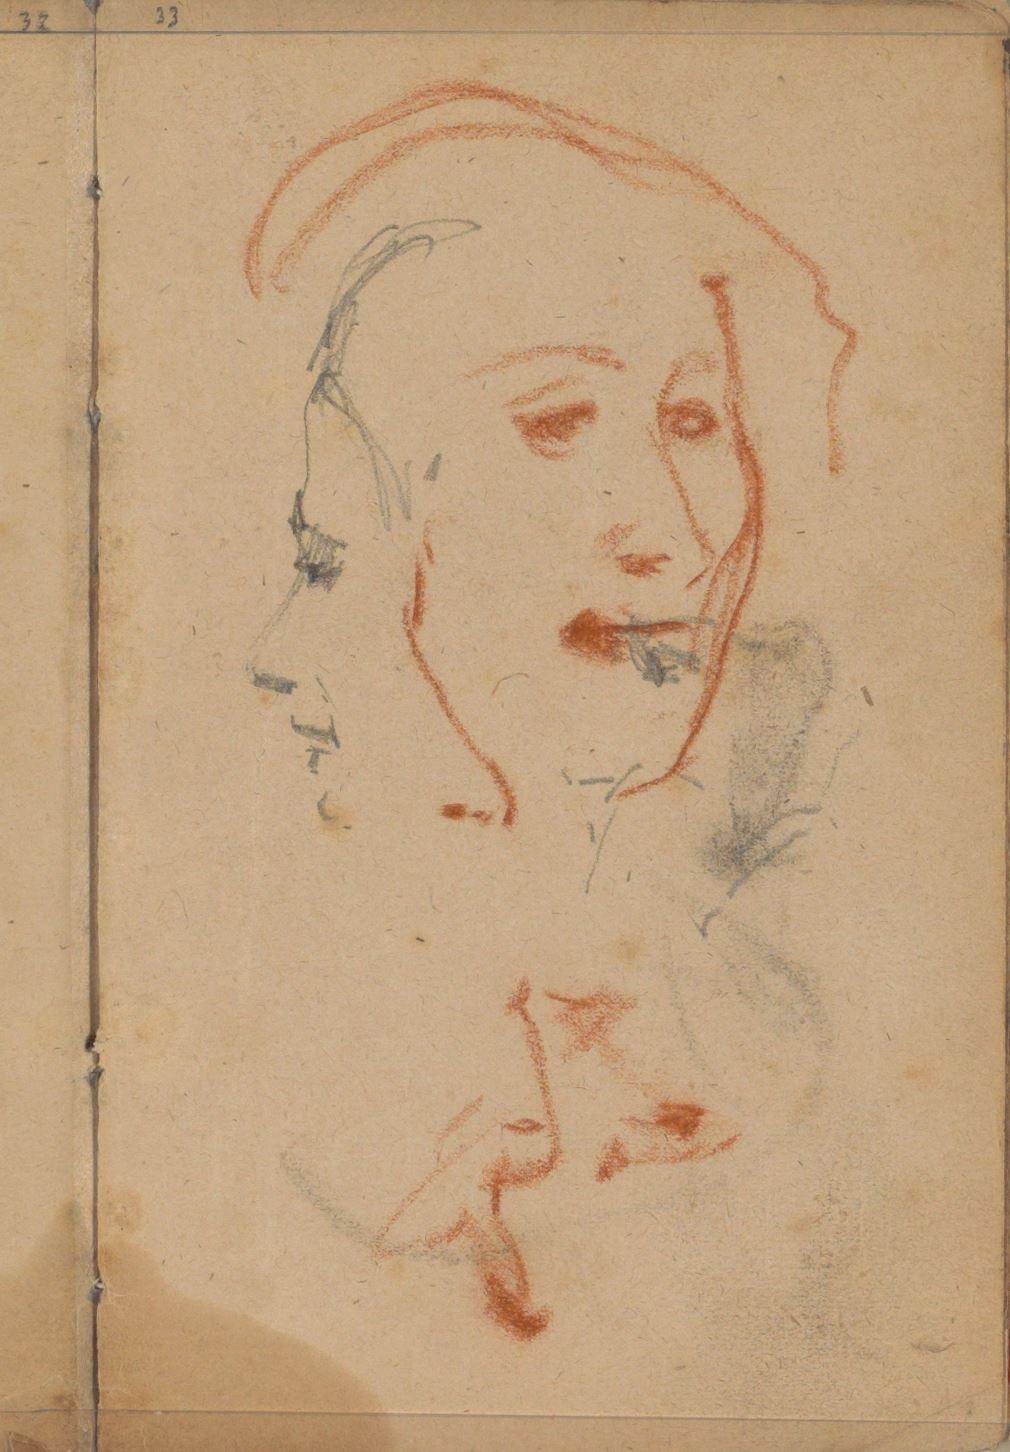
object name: sketchbook leaf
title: Gezichten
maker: george hendrik breitner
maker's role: draughtsman, painter, print maker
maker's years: 1857-1923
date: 1881-1883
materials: chalk, paper, pencil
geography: south holland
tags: face, face - aa - mask (mould taken from face)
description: Gezichten. Pagina 33 uit een schetsboek met 70 bladen.